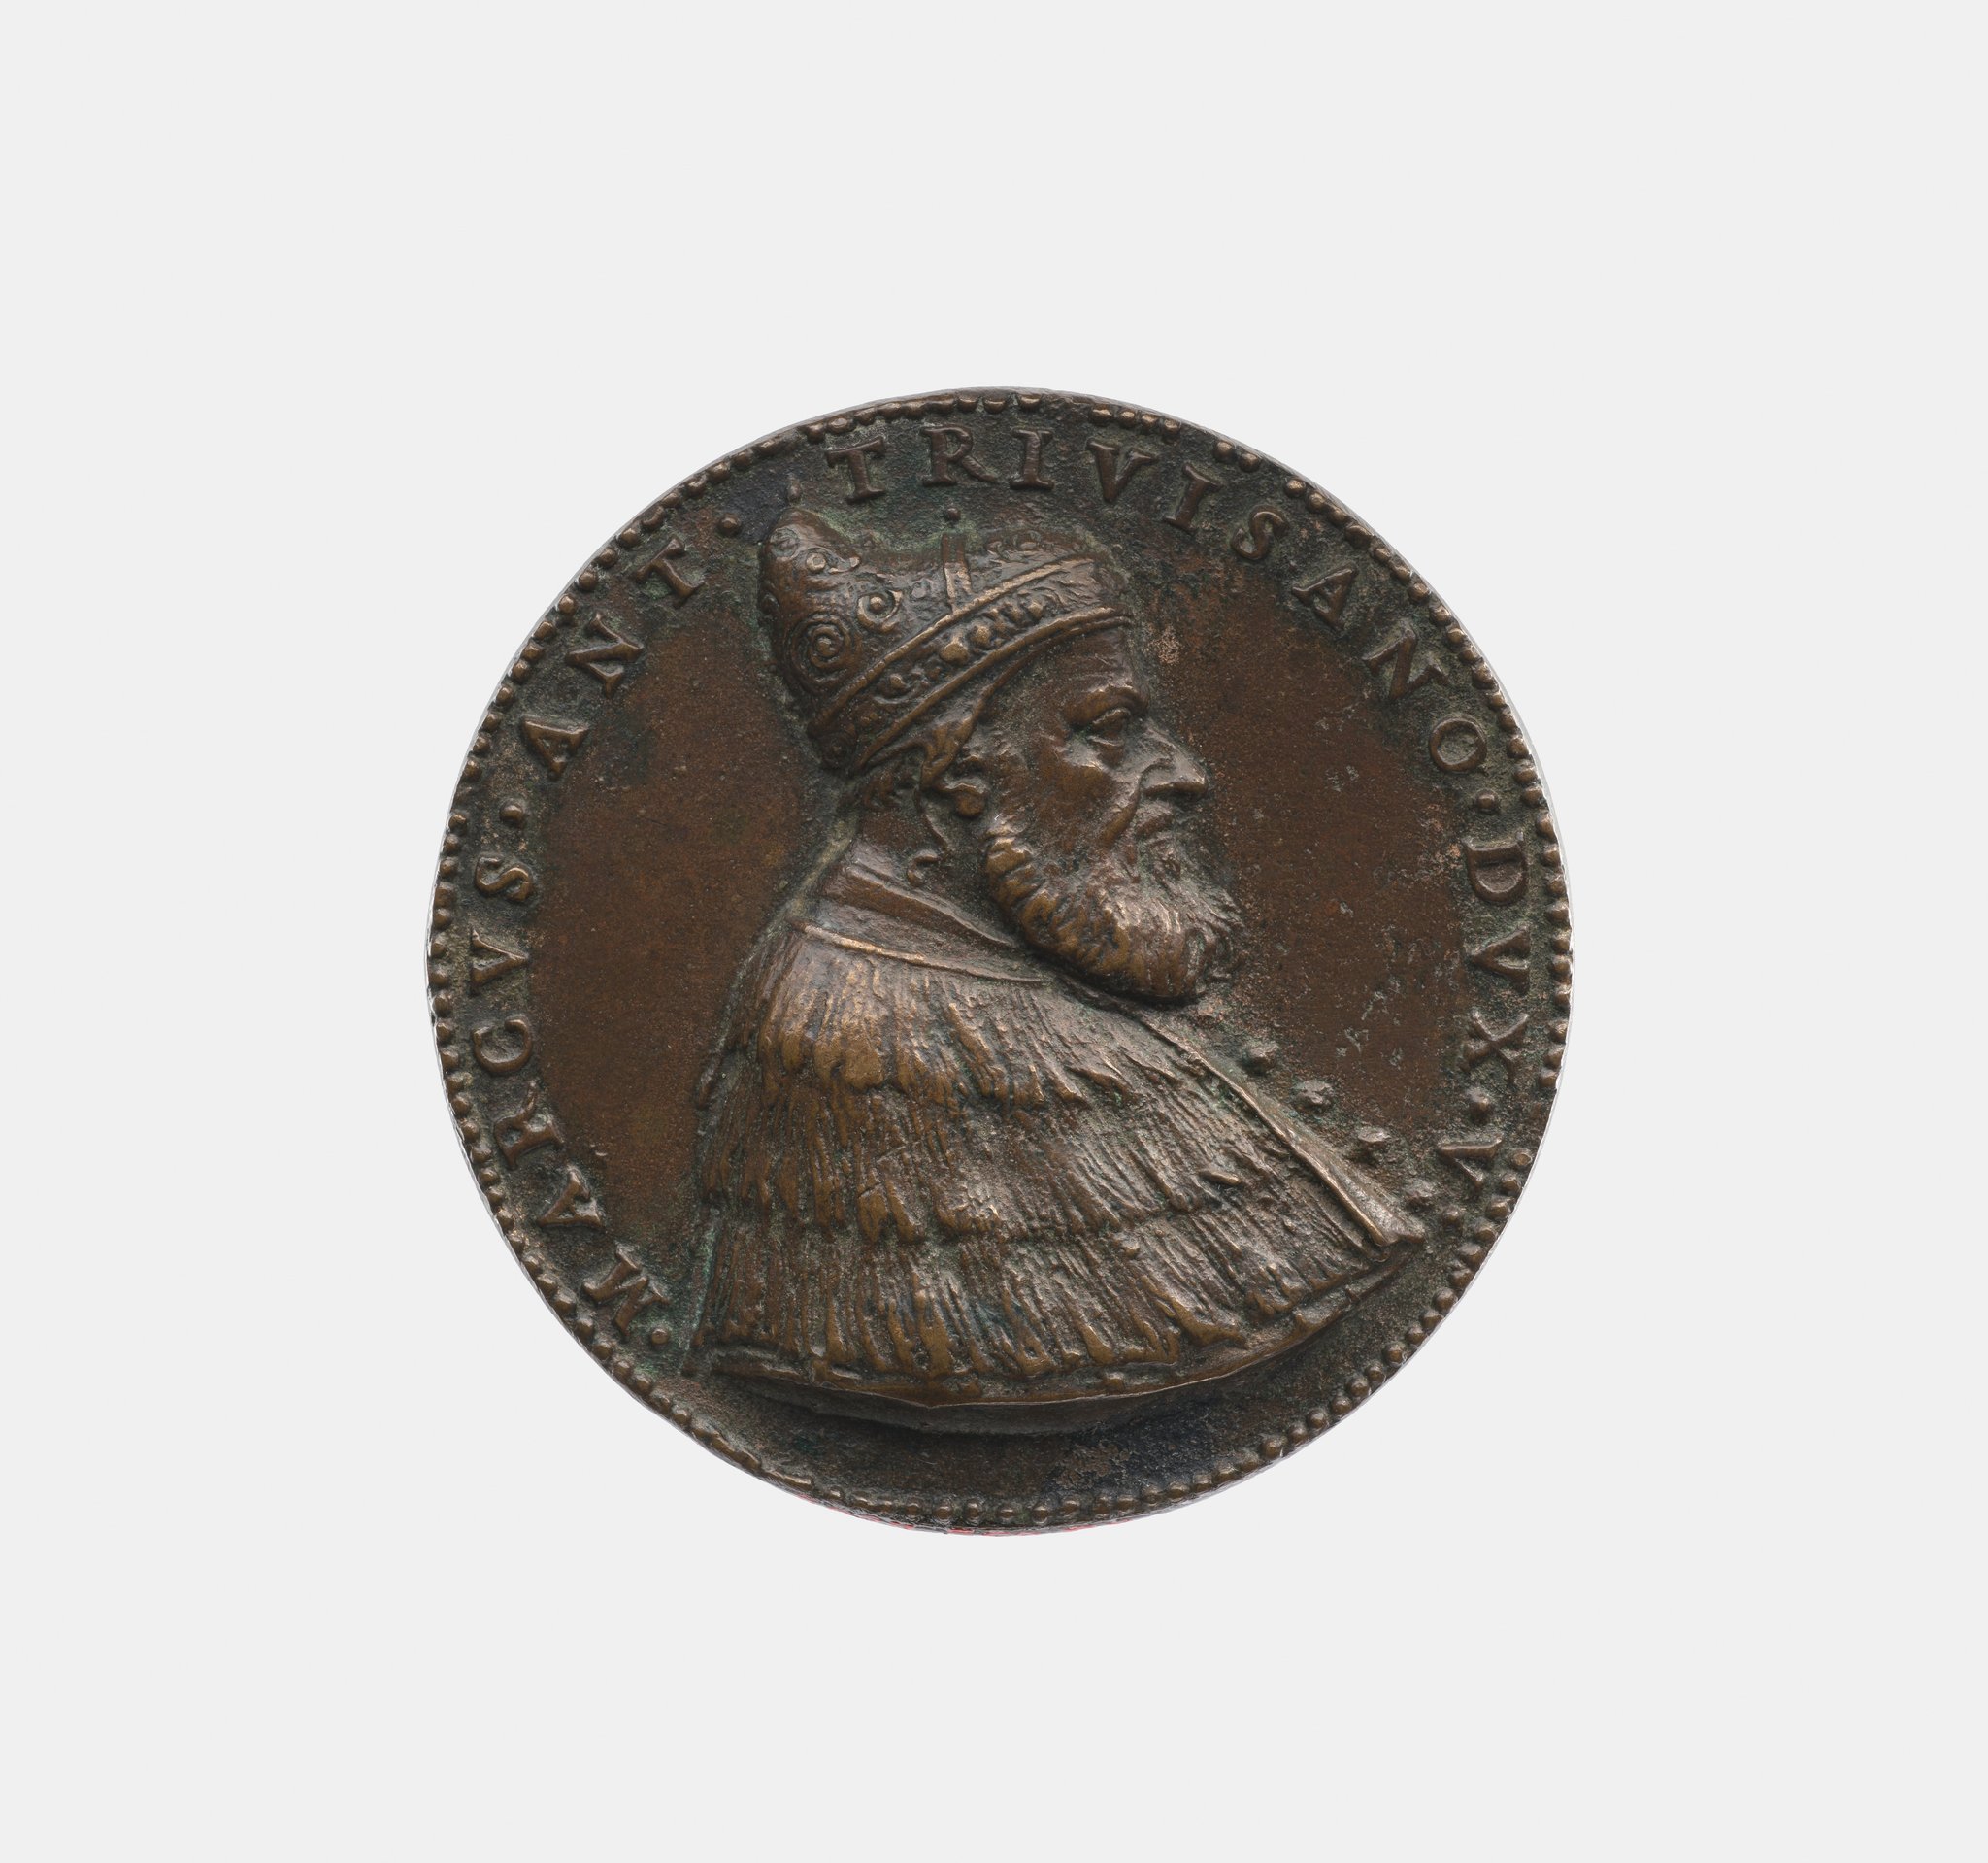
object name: medal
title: Marcantonio Trevisan, Doge of Venice 1553-54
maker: Anonymous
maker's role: artist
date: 1554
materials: bronze